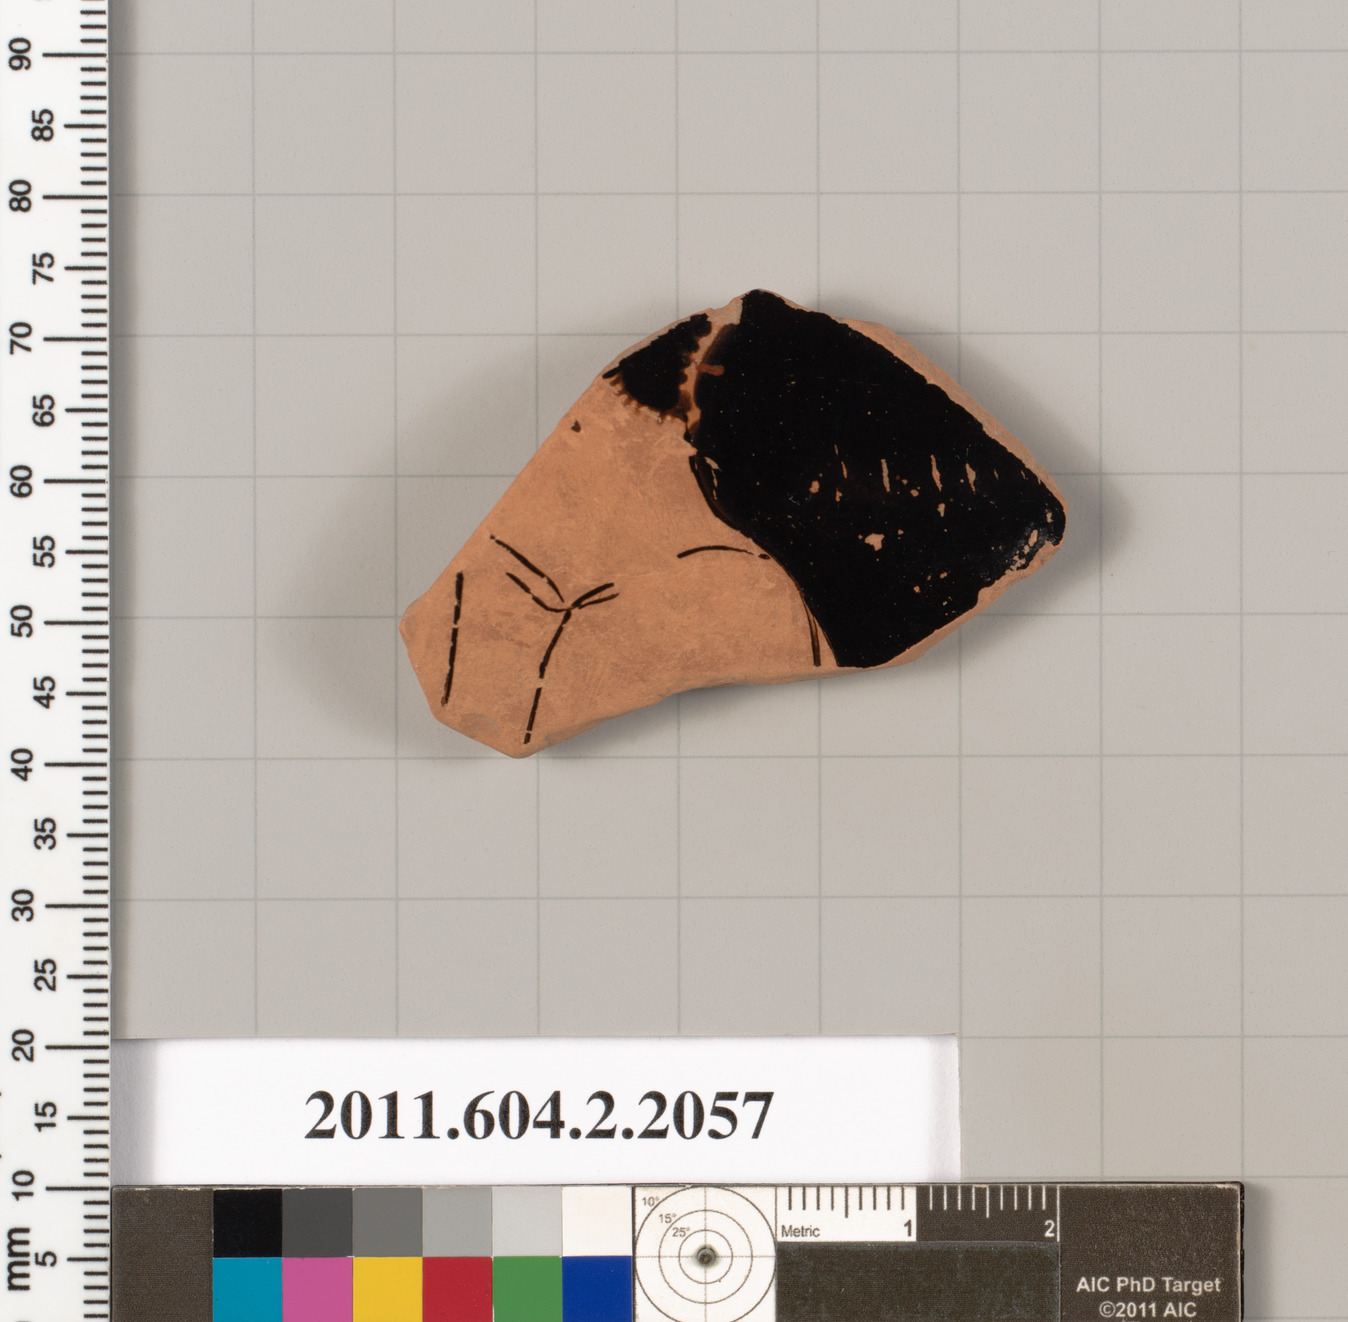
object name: krater fragment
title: Terracotta fragment of a column-krater (bowl for mixing wine and water)?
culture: greek, attic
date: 480-470 BCE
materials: terracotta